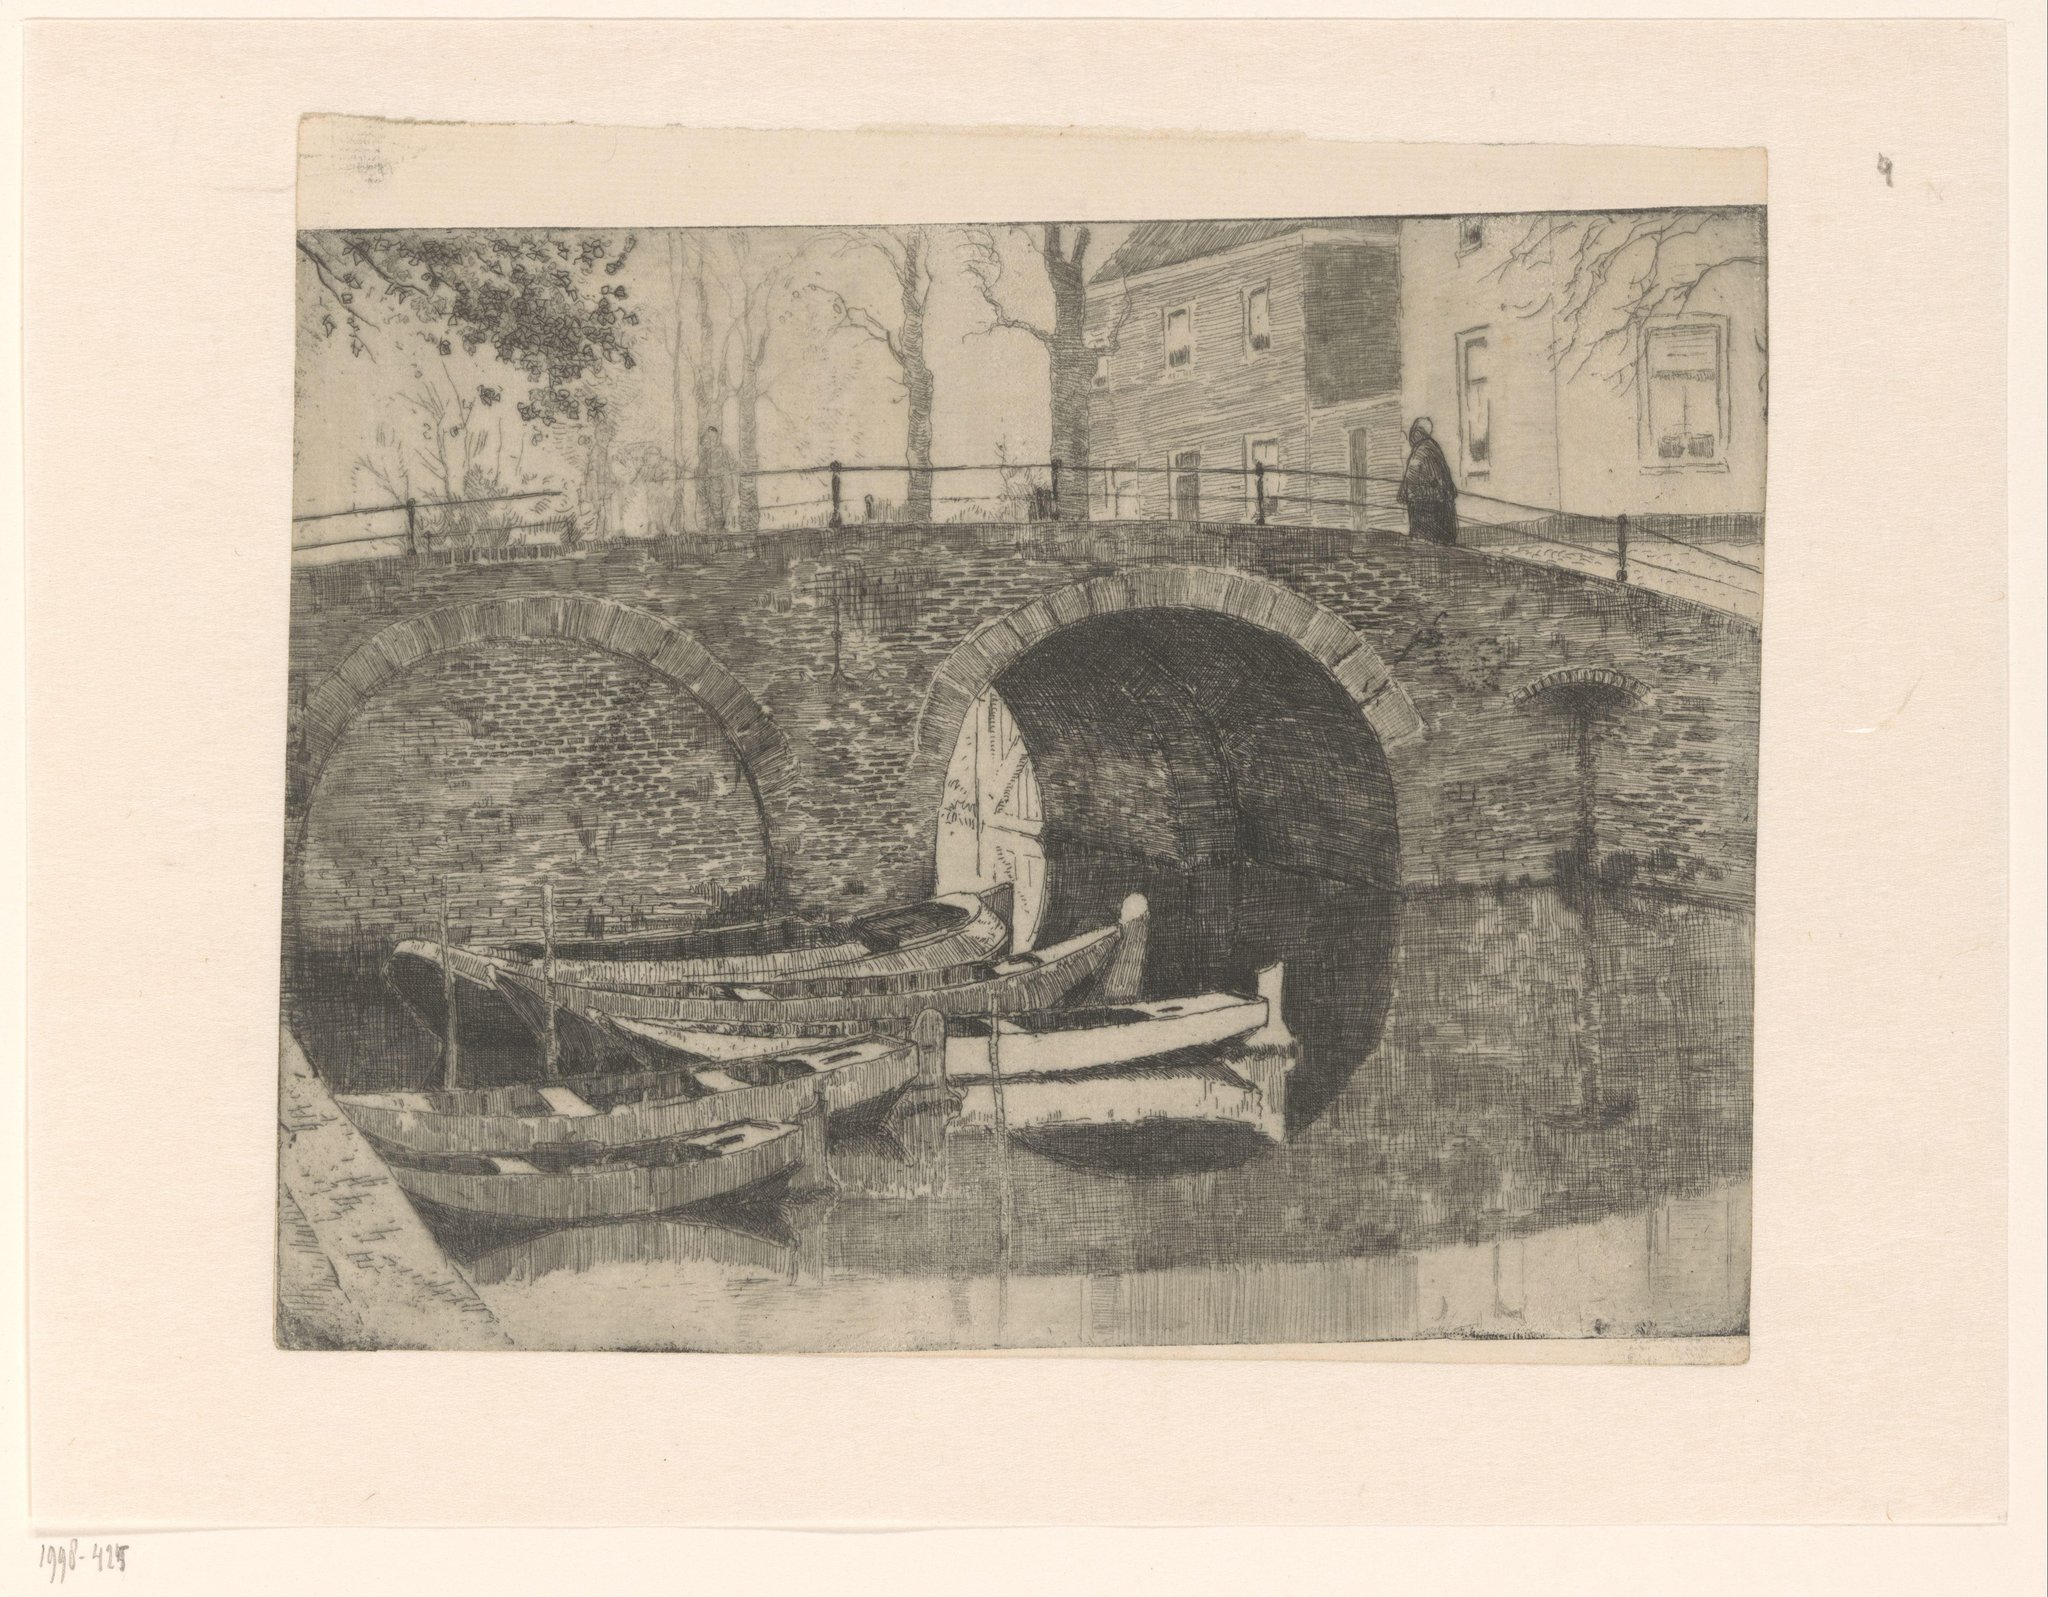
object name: print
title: Brug over een gracht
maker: cornelis vreedenburgh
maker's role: draughtsman, print maker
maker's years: 1880-1946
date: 1914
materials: paper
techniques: drypoint, etching, intaglio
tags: rowing-boat, canoe, etc., bridge in city across river, canal, etc.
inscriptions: collector's mark: Lugt 2228, collector's mark: Lugt 2760